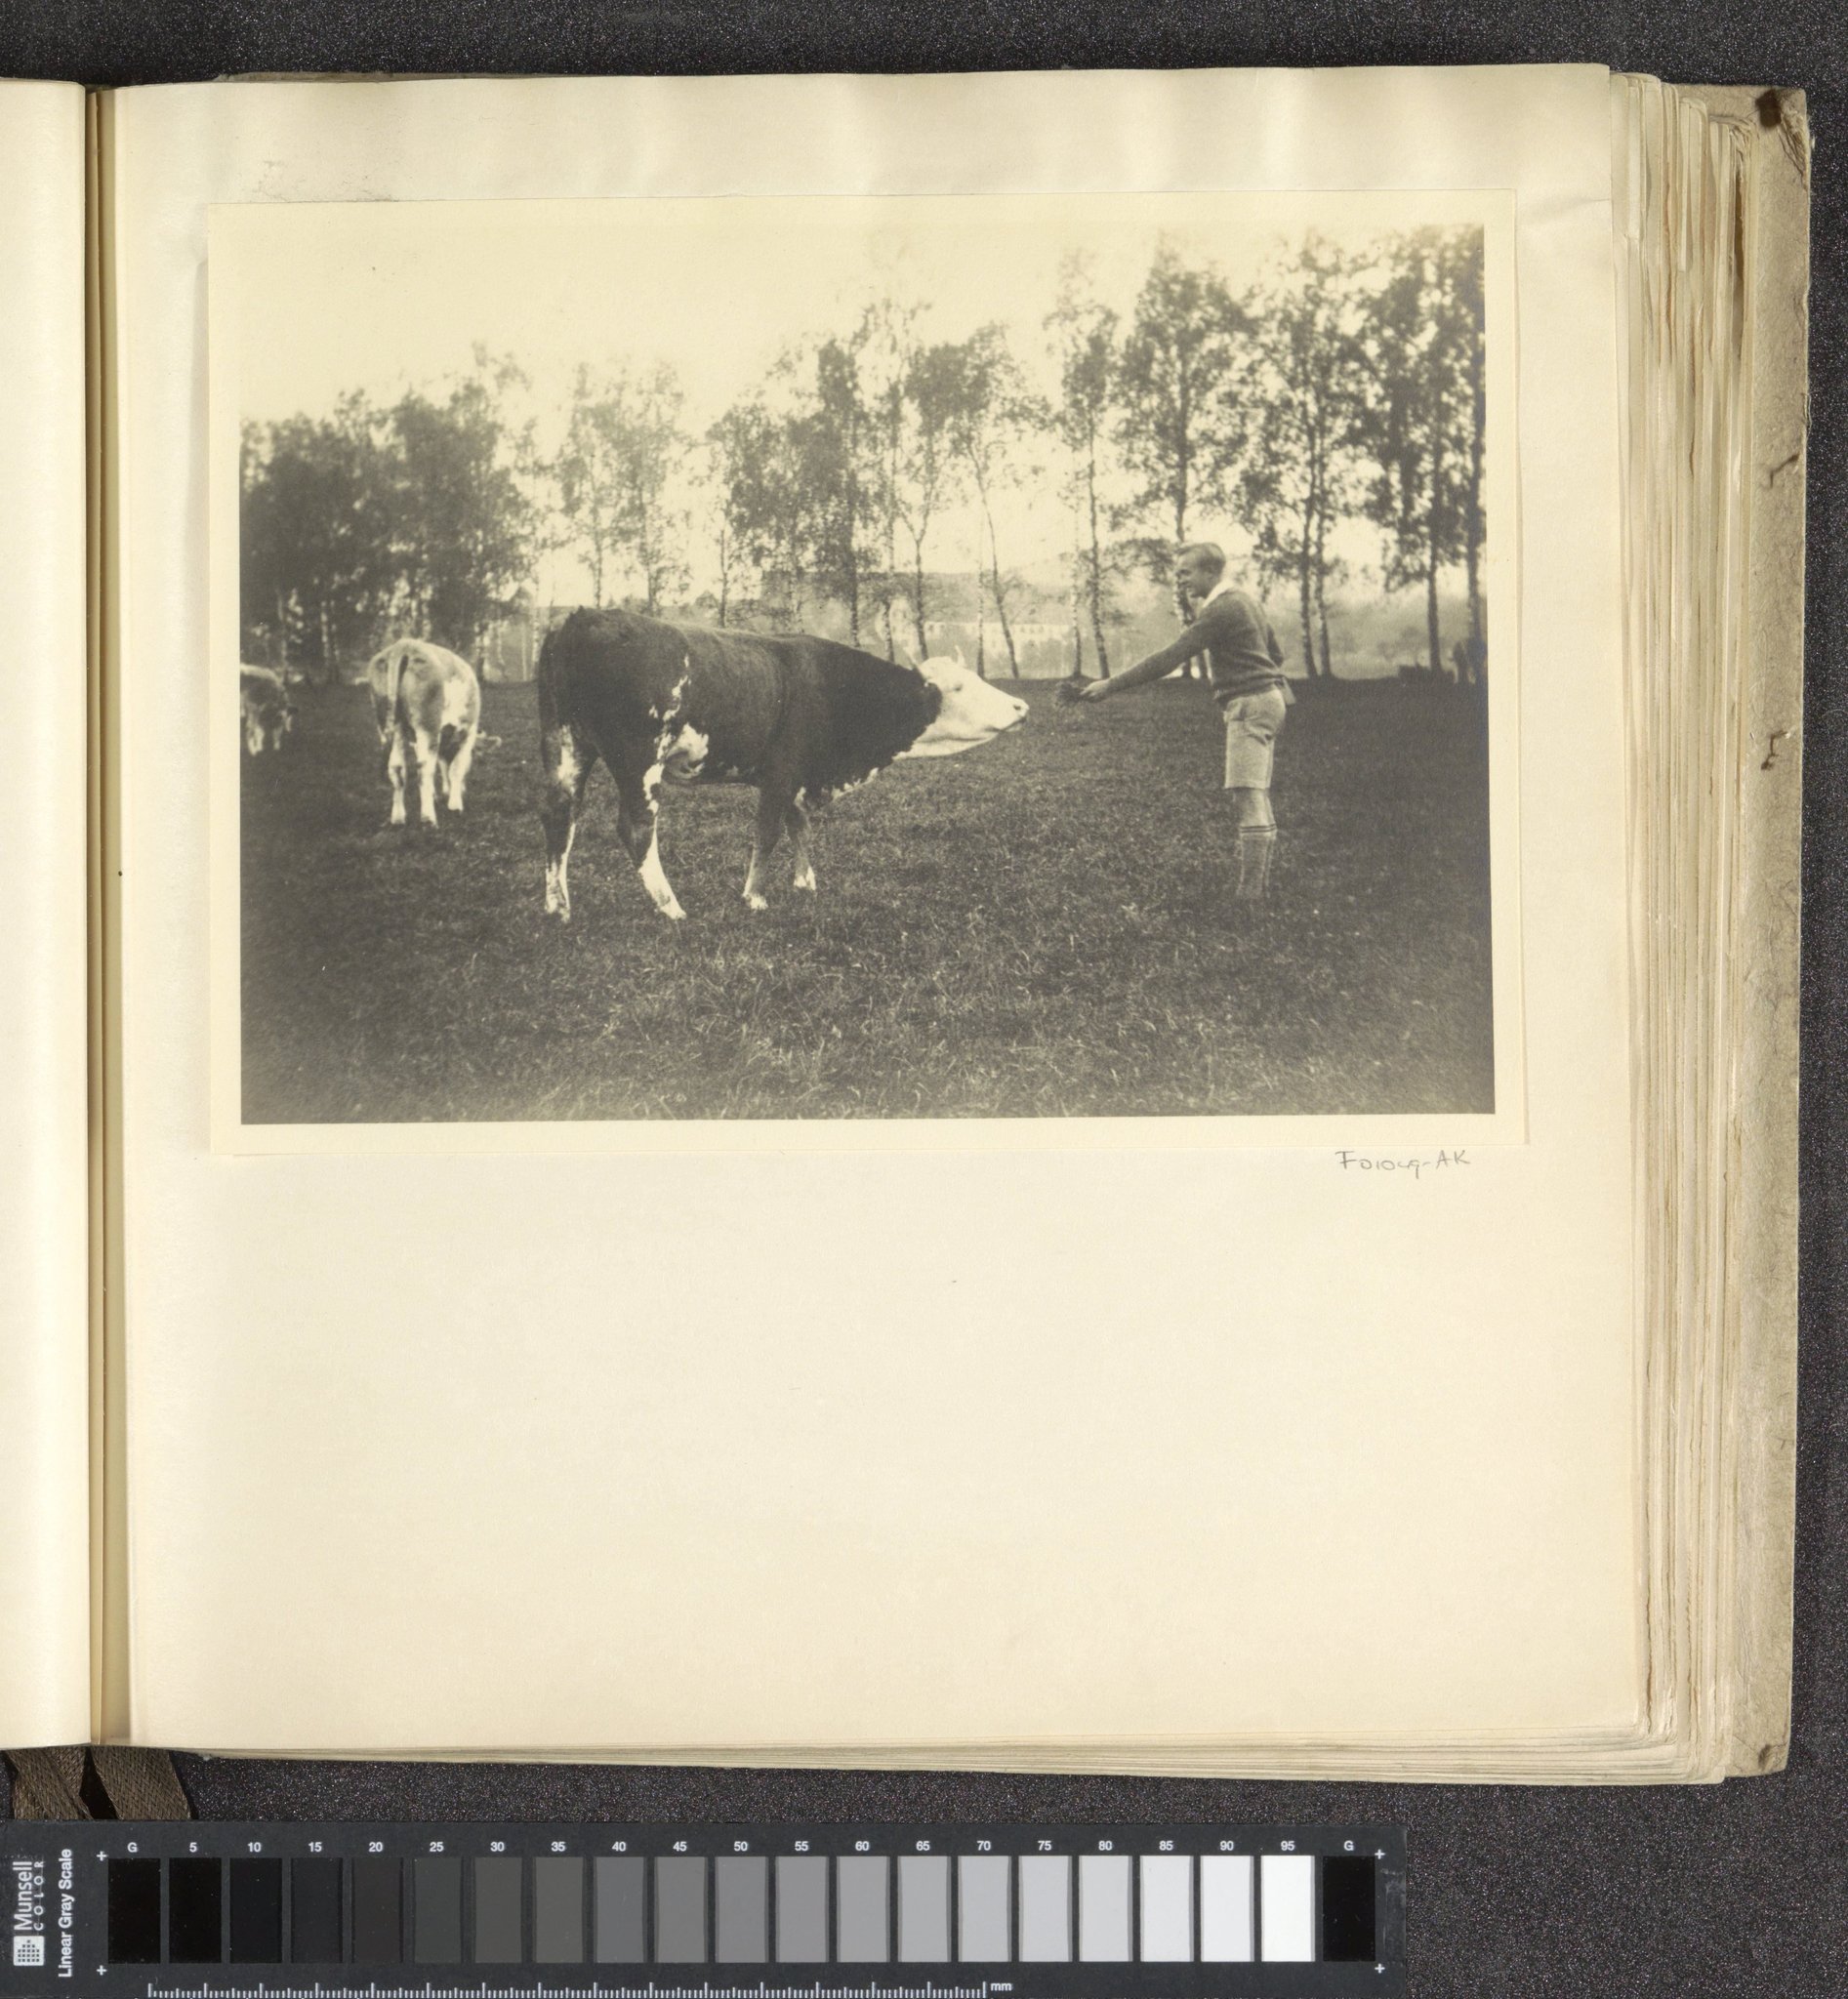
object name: photograph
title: Leerling van Schule Schloss Salem met koeien in een wei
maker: Anonymous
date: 1929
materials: photographic support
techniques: gelatin silver print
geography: salem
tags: cow, education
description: Onderdeel van Fotoalbum van Schule Schloss Salem.